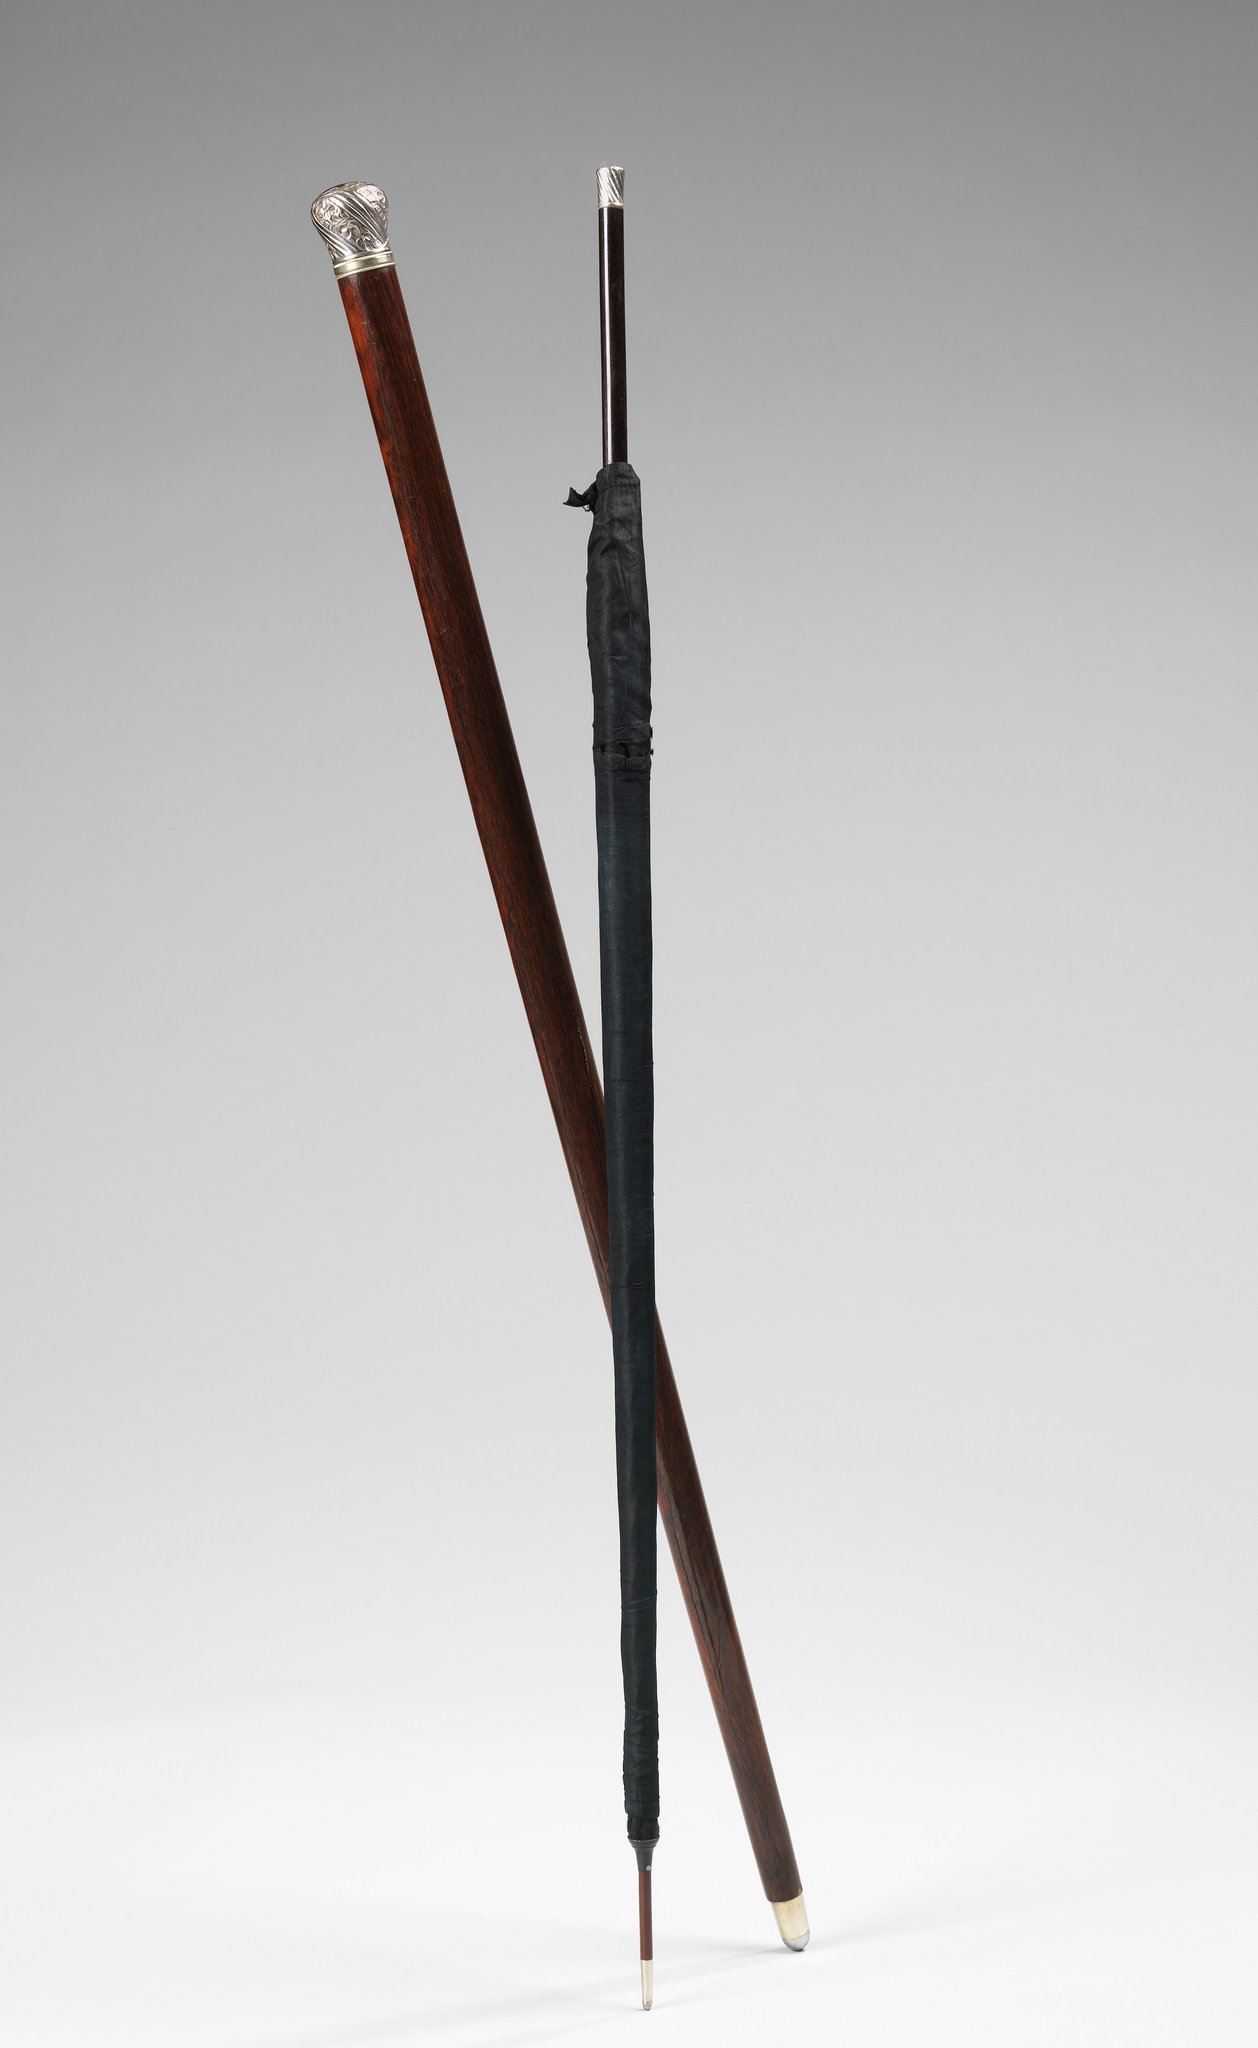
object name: cane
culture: american or european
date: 1880-1889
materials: metal, silk, wood, wool